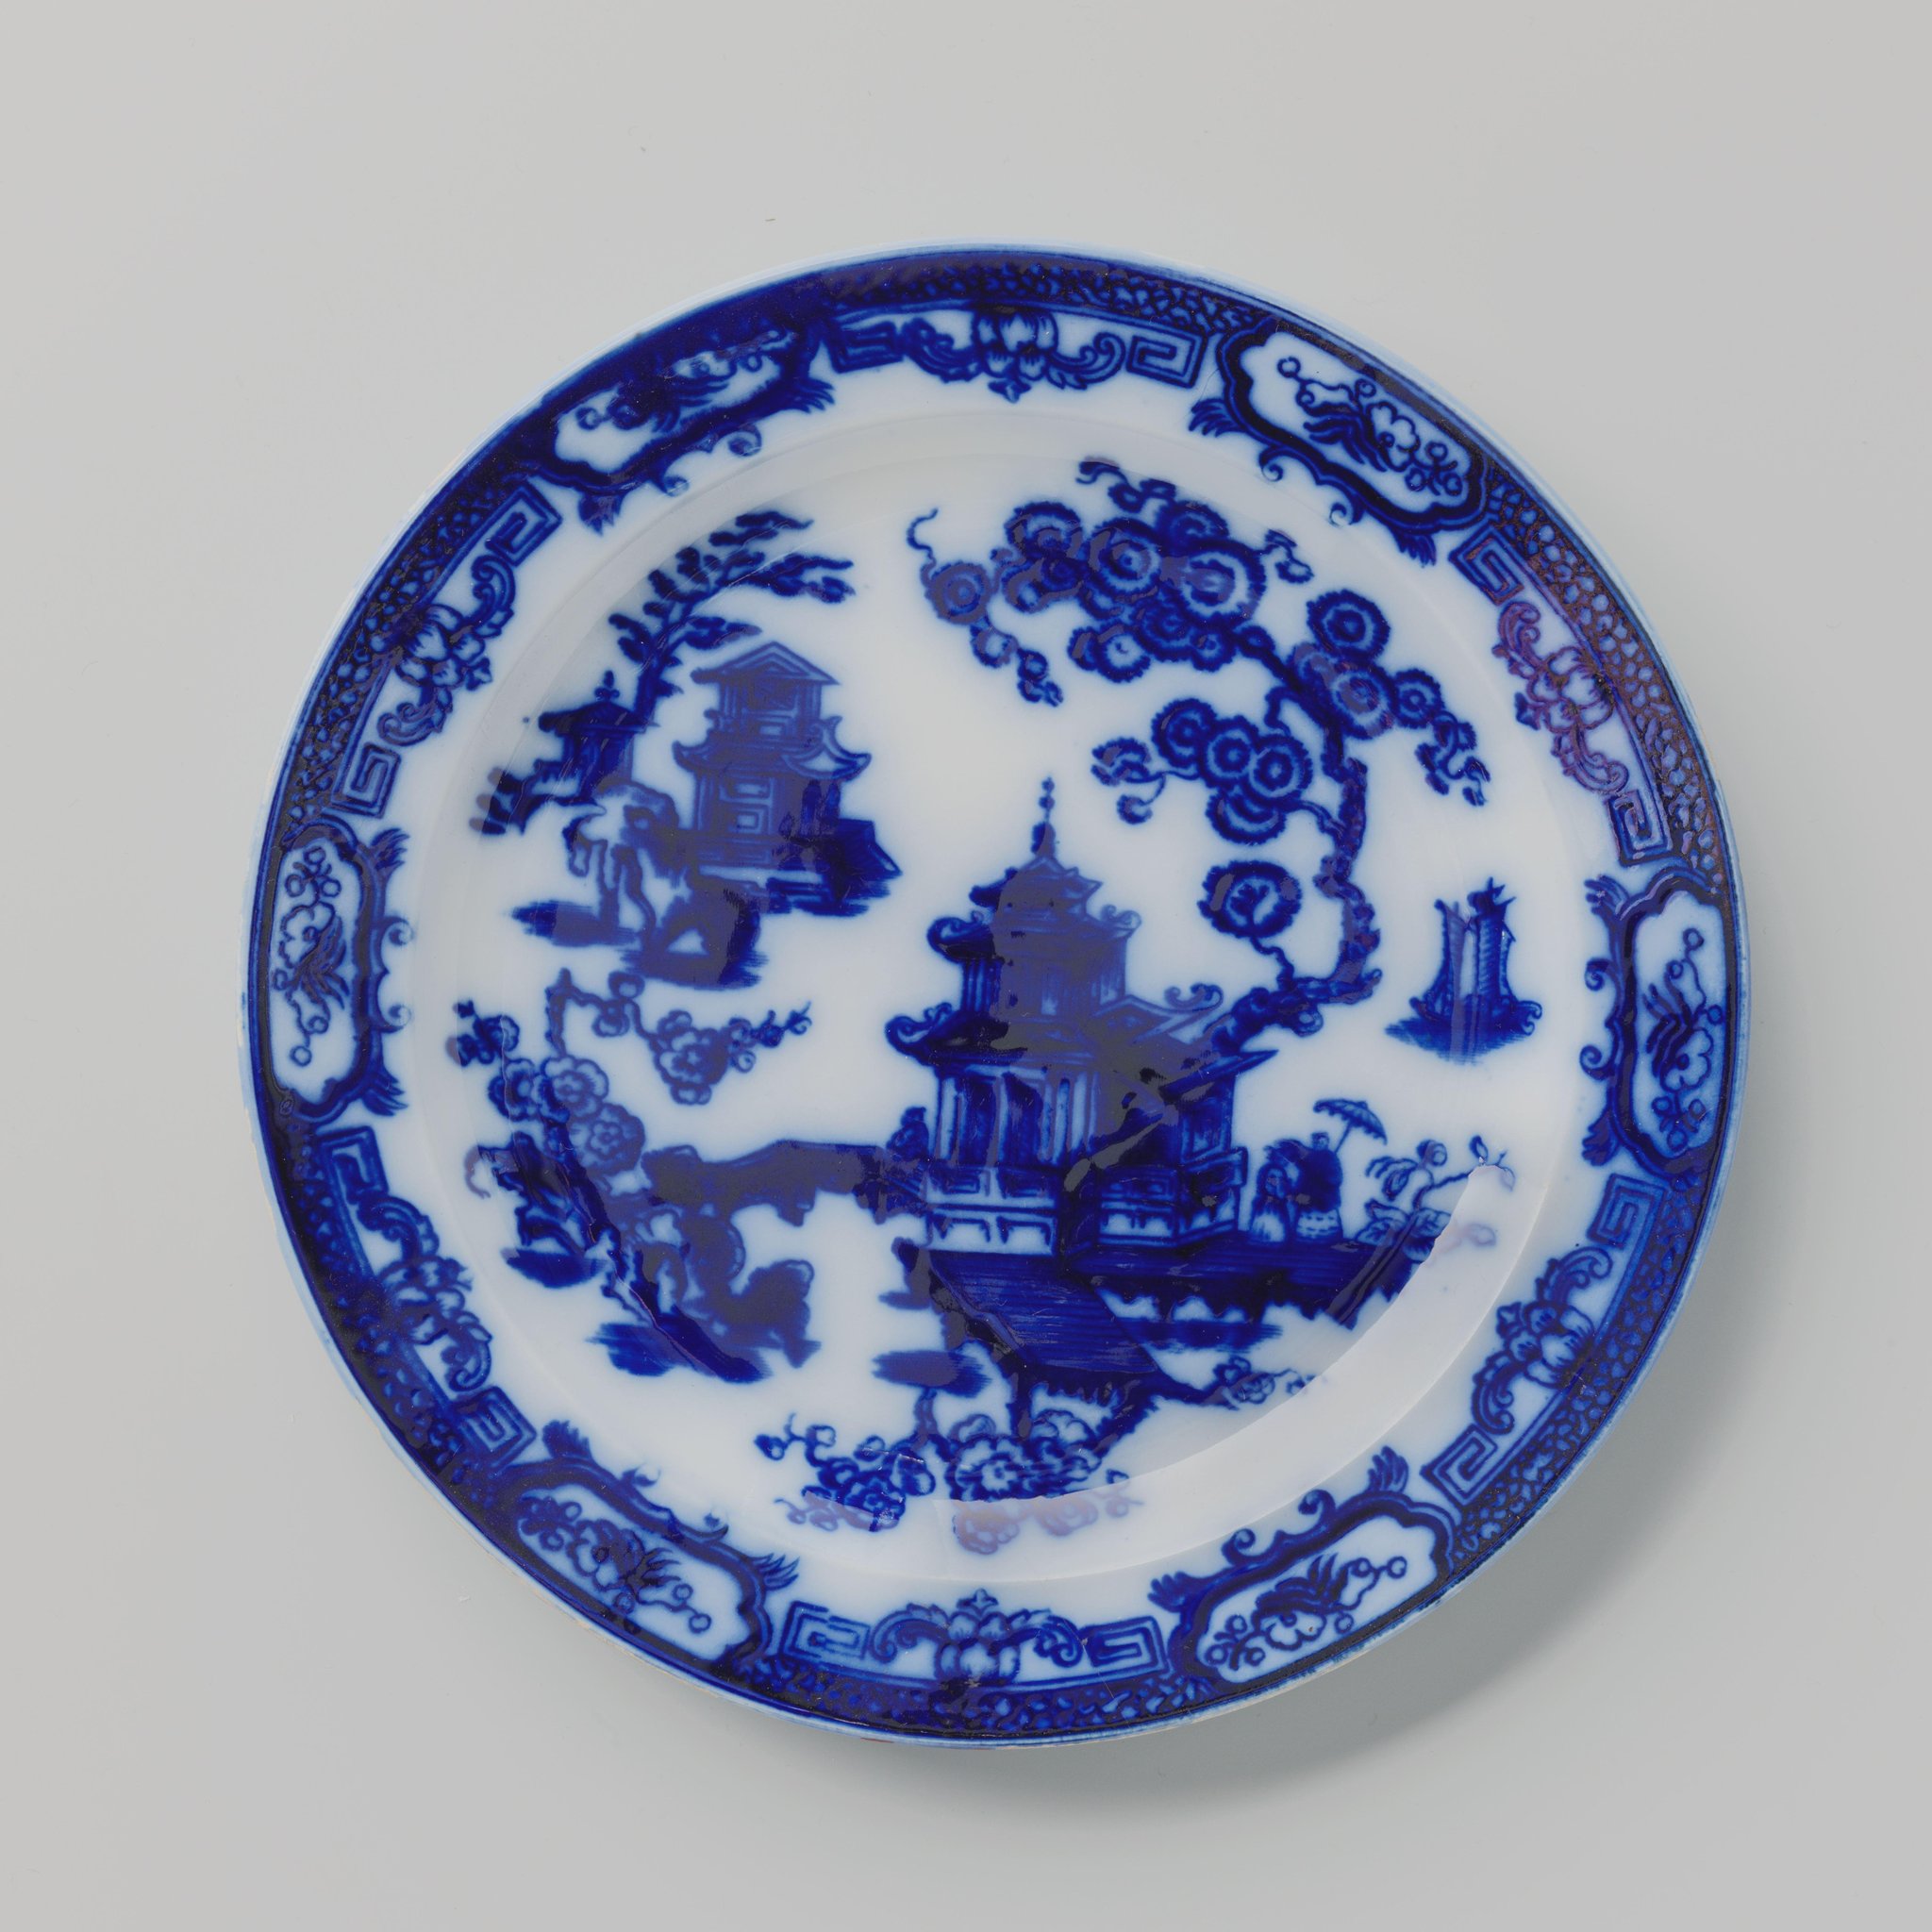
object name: plate dish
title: Bord, met op het plat Chinese gebouwen en bloeiende takken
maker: petrus regout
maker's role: plateelbakker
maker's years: 1801-1879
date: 1860-1890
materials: creamware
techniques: transfer decoration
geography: maastricht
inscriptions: mark: ‘M’, mark: ‘MAASTRICHT PR’, check stamp: ‘PR 15 (?)’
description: Bord van aardewerk met vloeiblauw transferdecor. Op het plat enige Chinese gebouwen en bloeiende takken los over het oppervlak verspreid. De rand van het bord met zes cartouches met bloemen. Tussen de cartouches abstracte motieven en bladwerk.